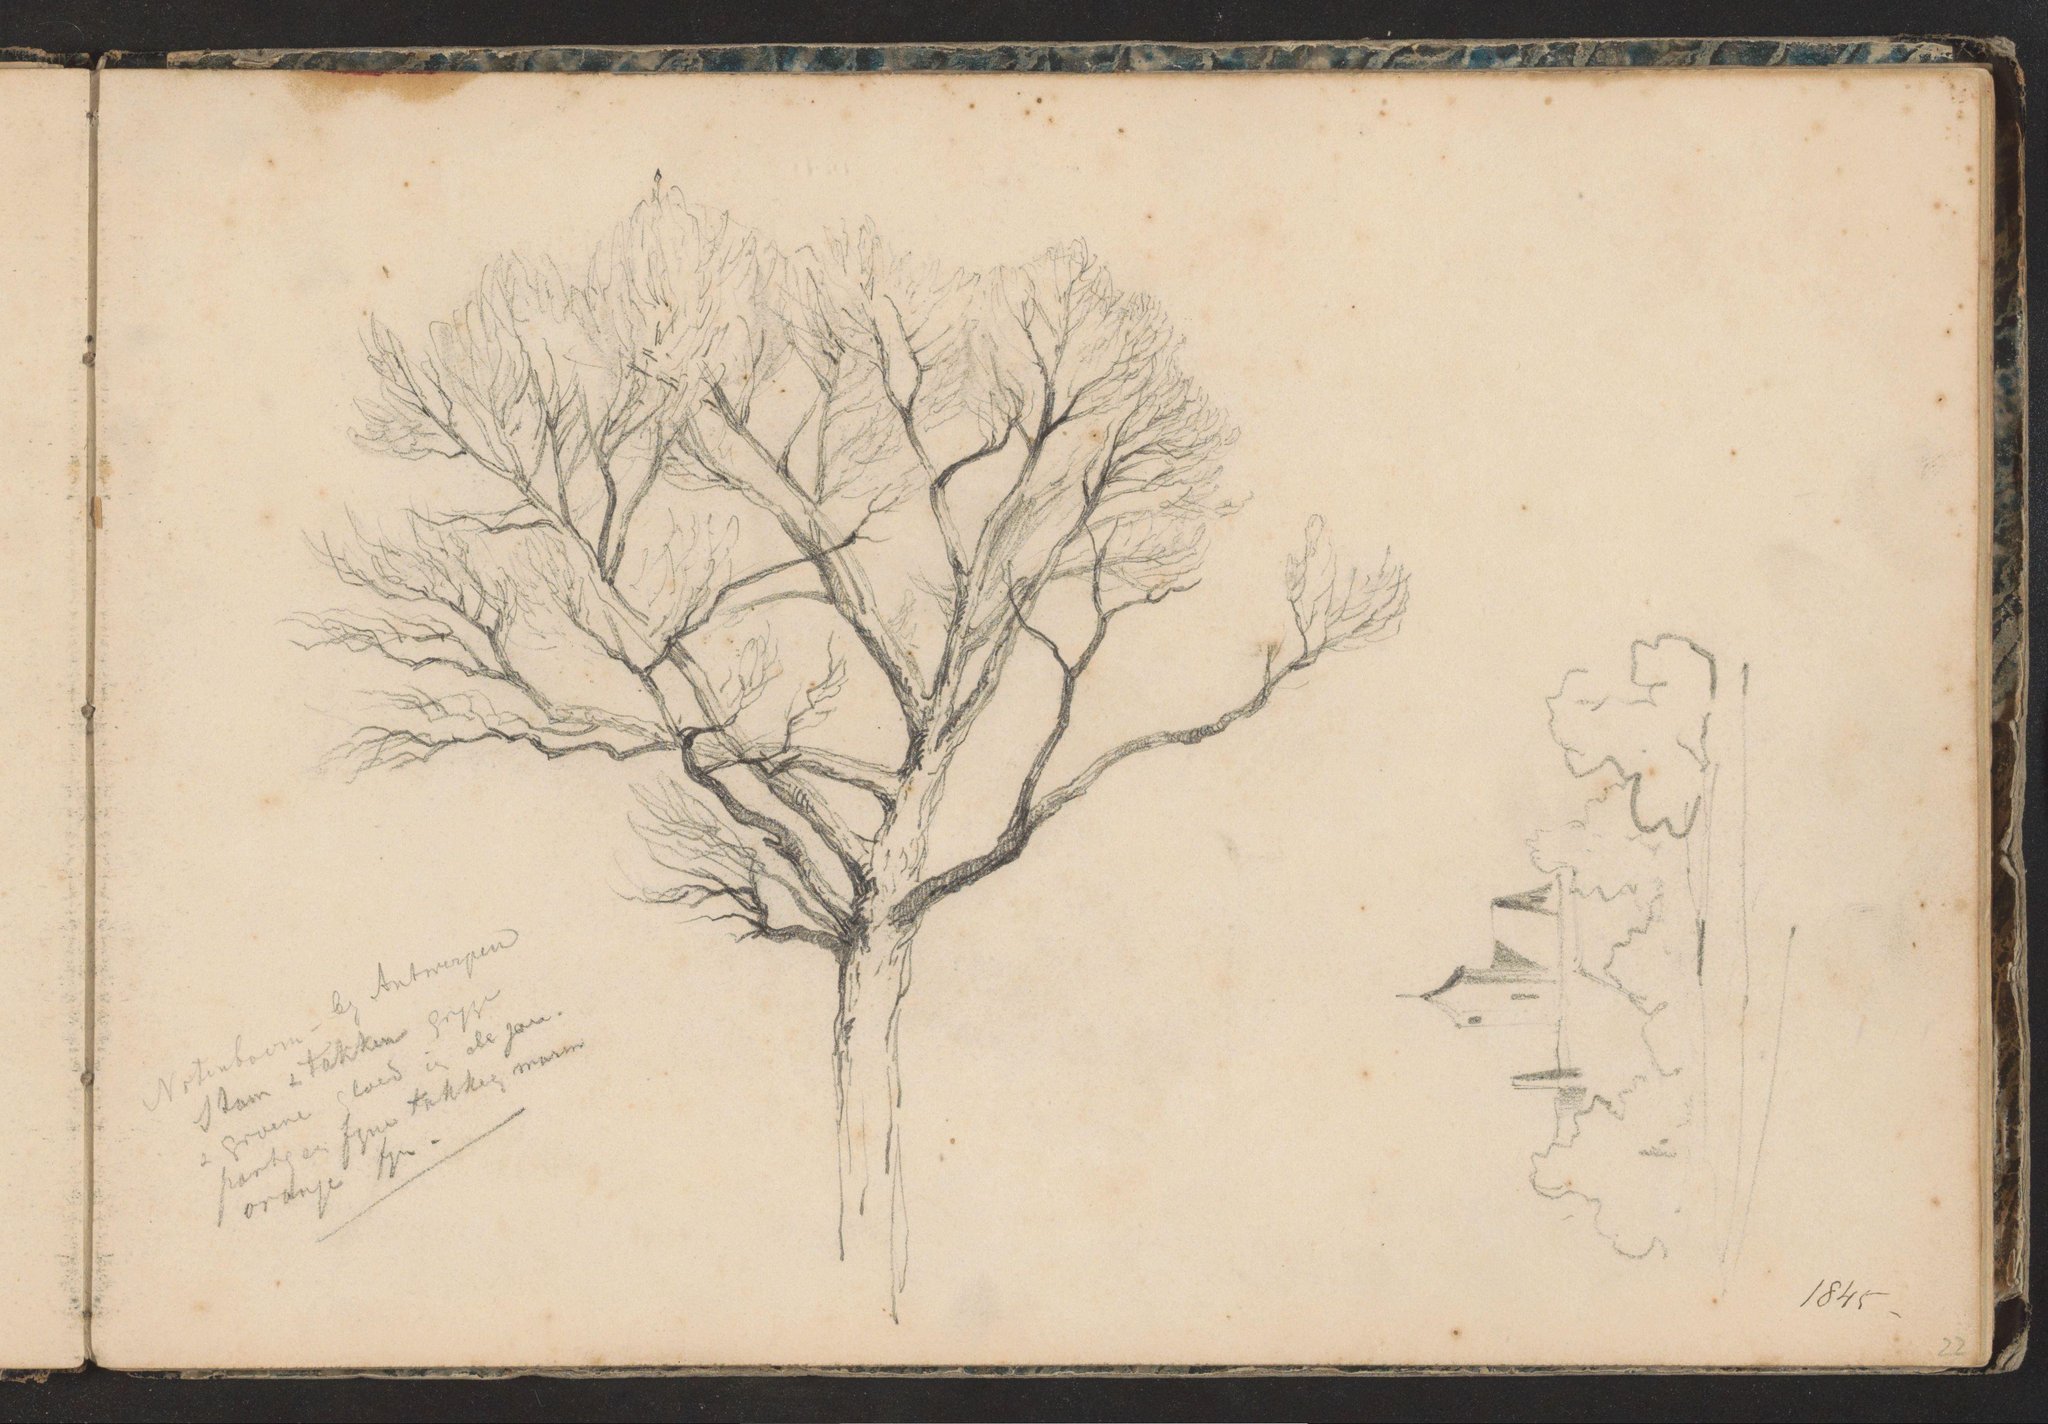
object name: sketchbook leaf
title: Notenboom bij Antwerpen en een stadsgezicht met een kerk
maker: johannes tavenraat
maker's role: draughtsman, painter, print maker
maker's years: 1809-1881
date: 1845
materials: paper, pencil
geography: antwerp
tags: city-view, and landscape with man-made constructions, trees: walnut-tree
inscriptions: date and inscription: ‘Notenboom - bij Antwerpen [...]/ 1845’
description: Blad 22 recto uit een schetsboek met 44 bladen.